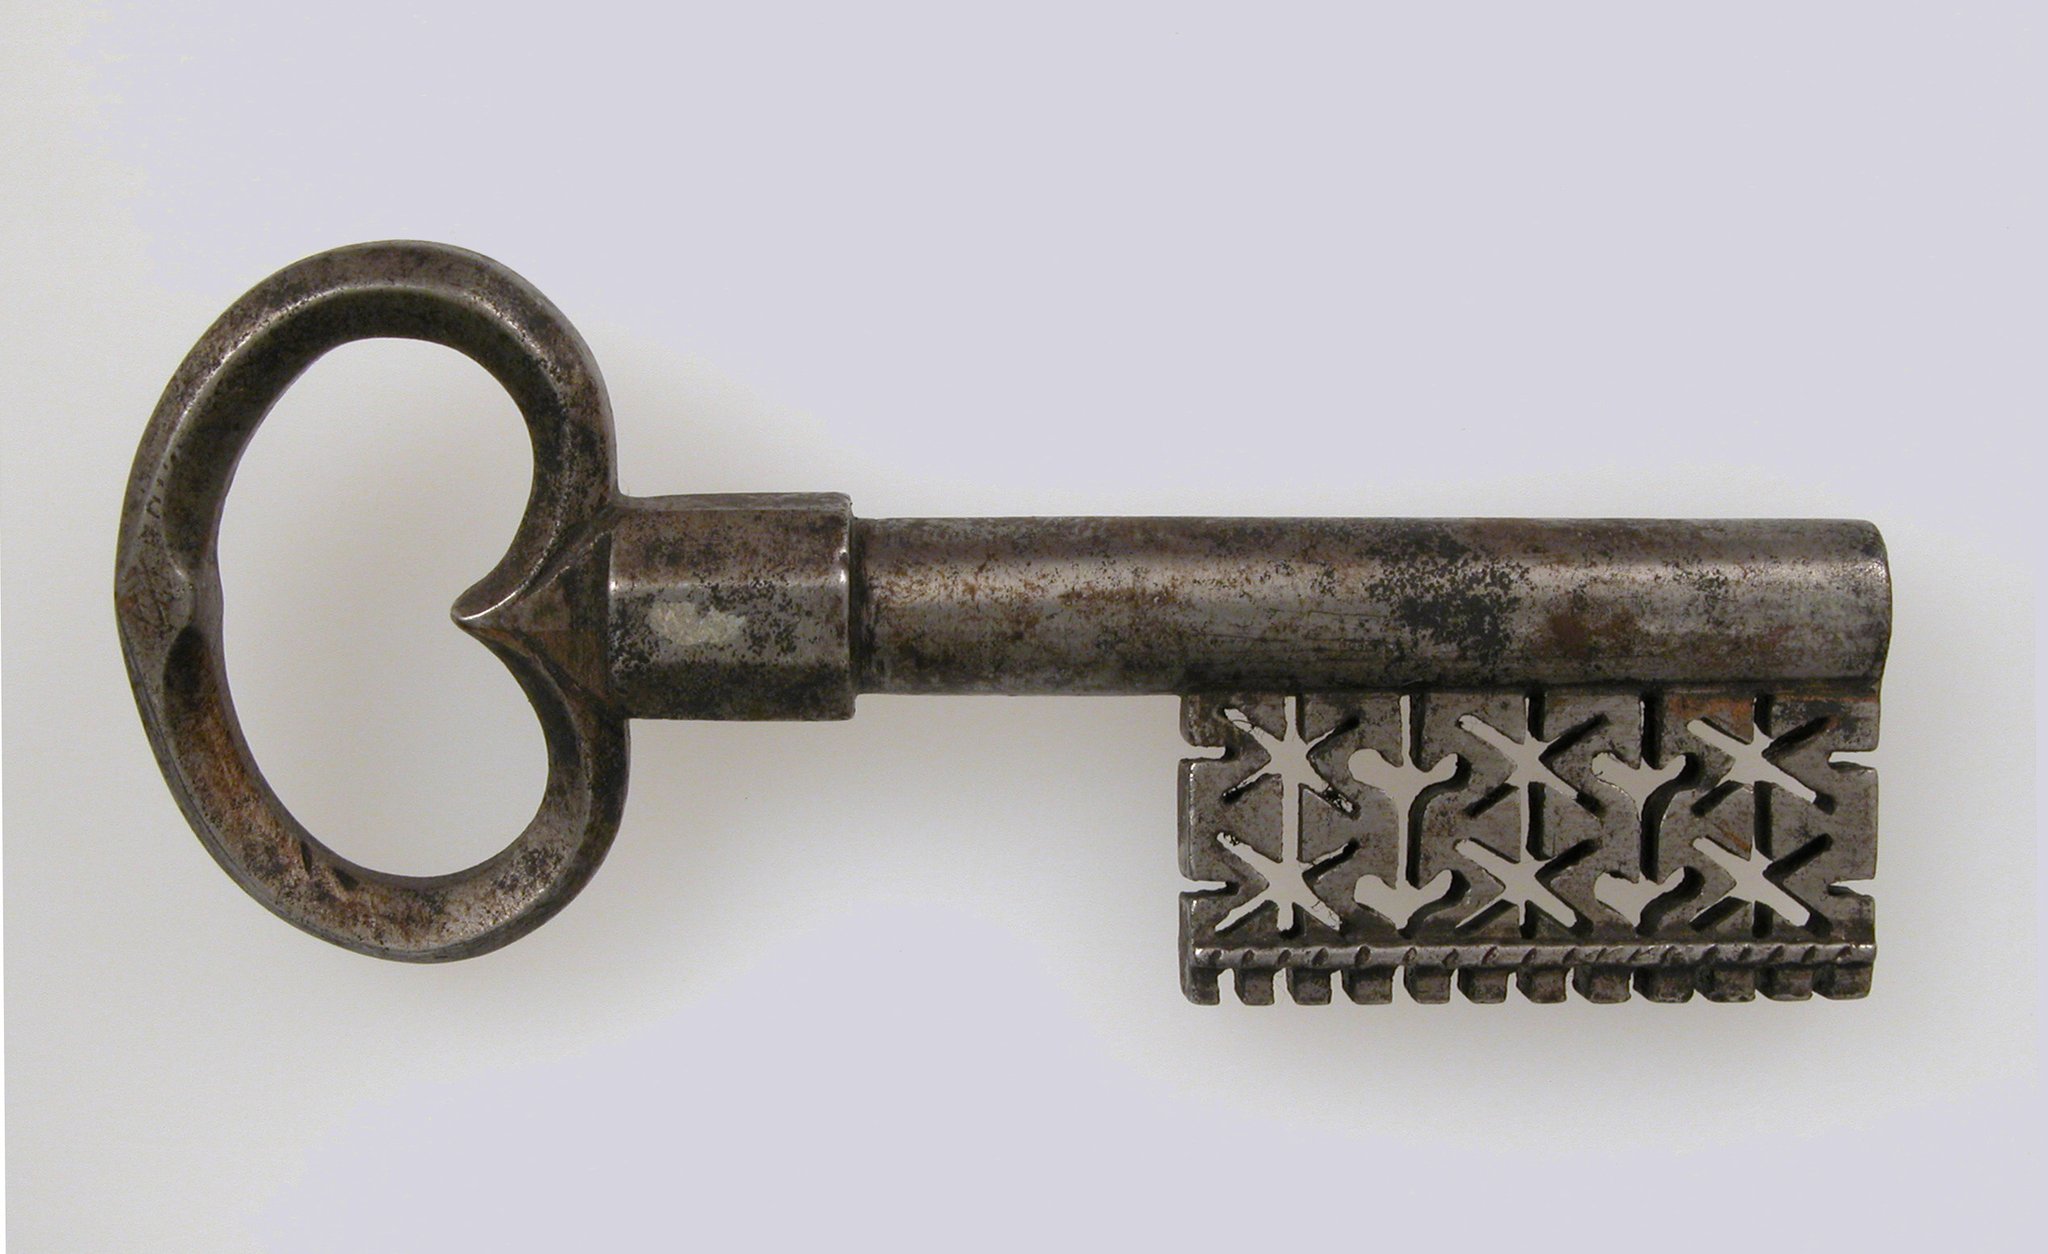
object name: key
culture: german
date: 1401-1500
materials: iron